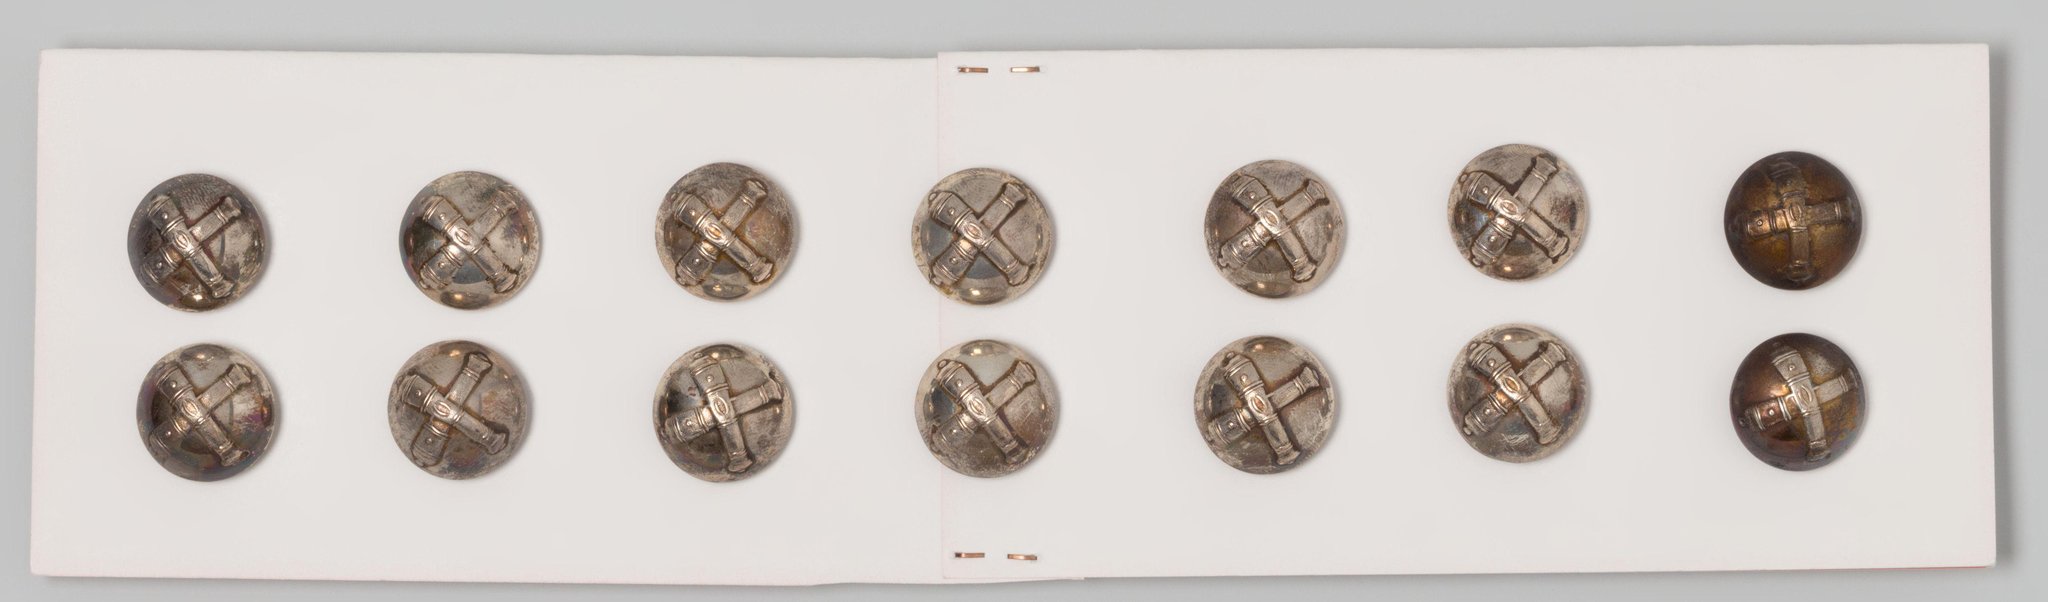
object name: uniform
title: Bolvormige knoop van verzilverd koper, waarop twee gekruiste kanonnen in reliëf; onderdeel van een artillerie-uniform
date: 1885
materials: copper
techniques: silvering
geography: the hague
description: Geborgen in een doos bij een sjerp; notitie in doos: "W. Six 1859-1928/14 knoopen schutterij uniform/1885".